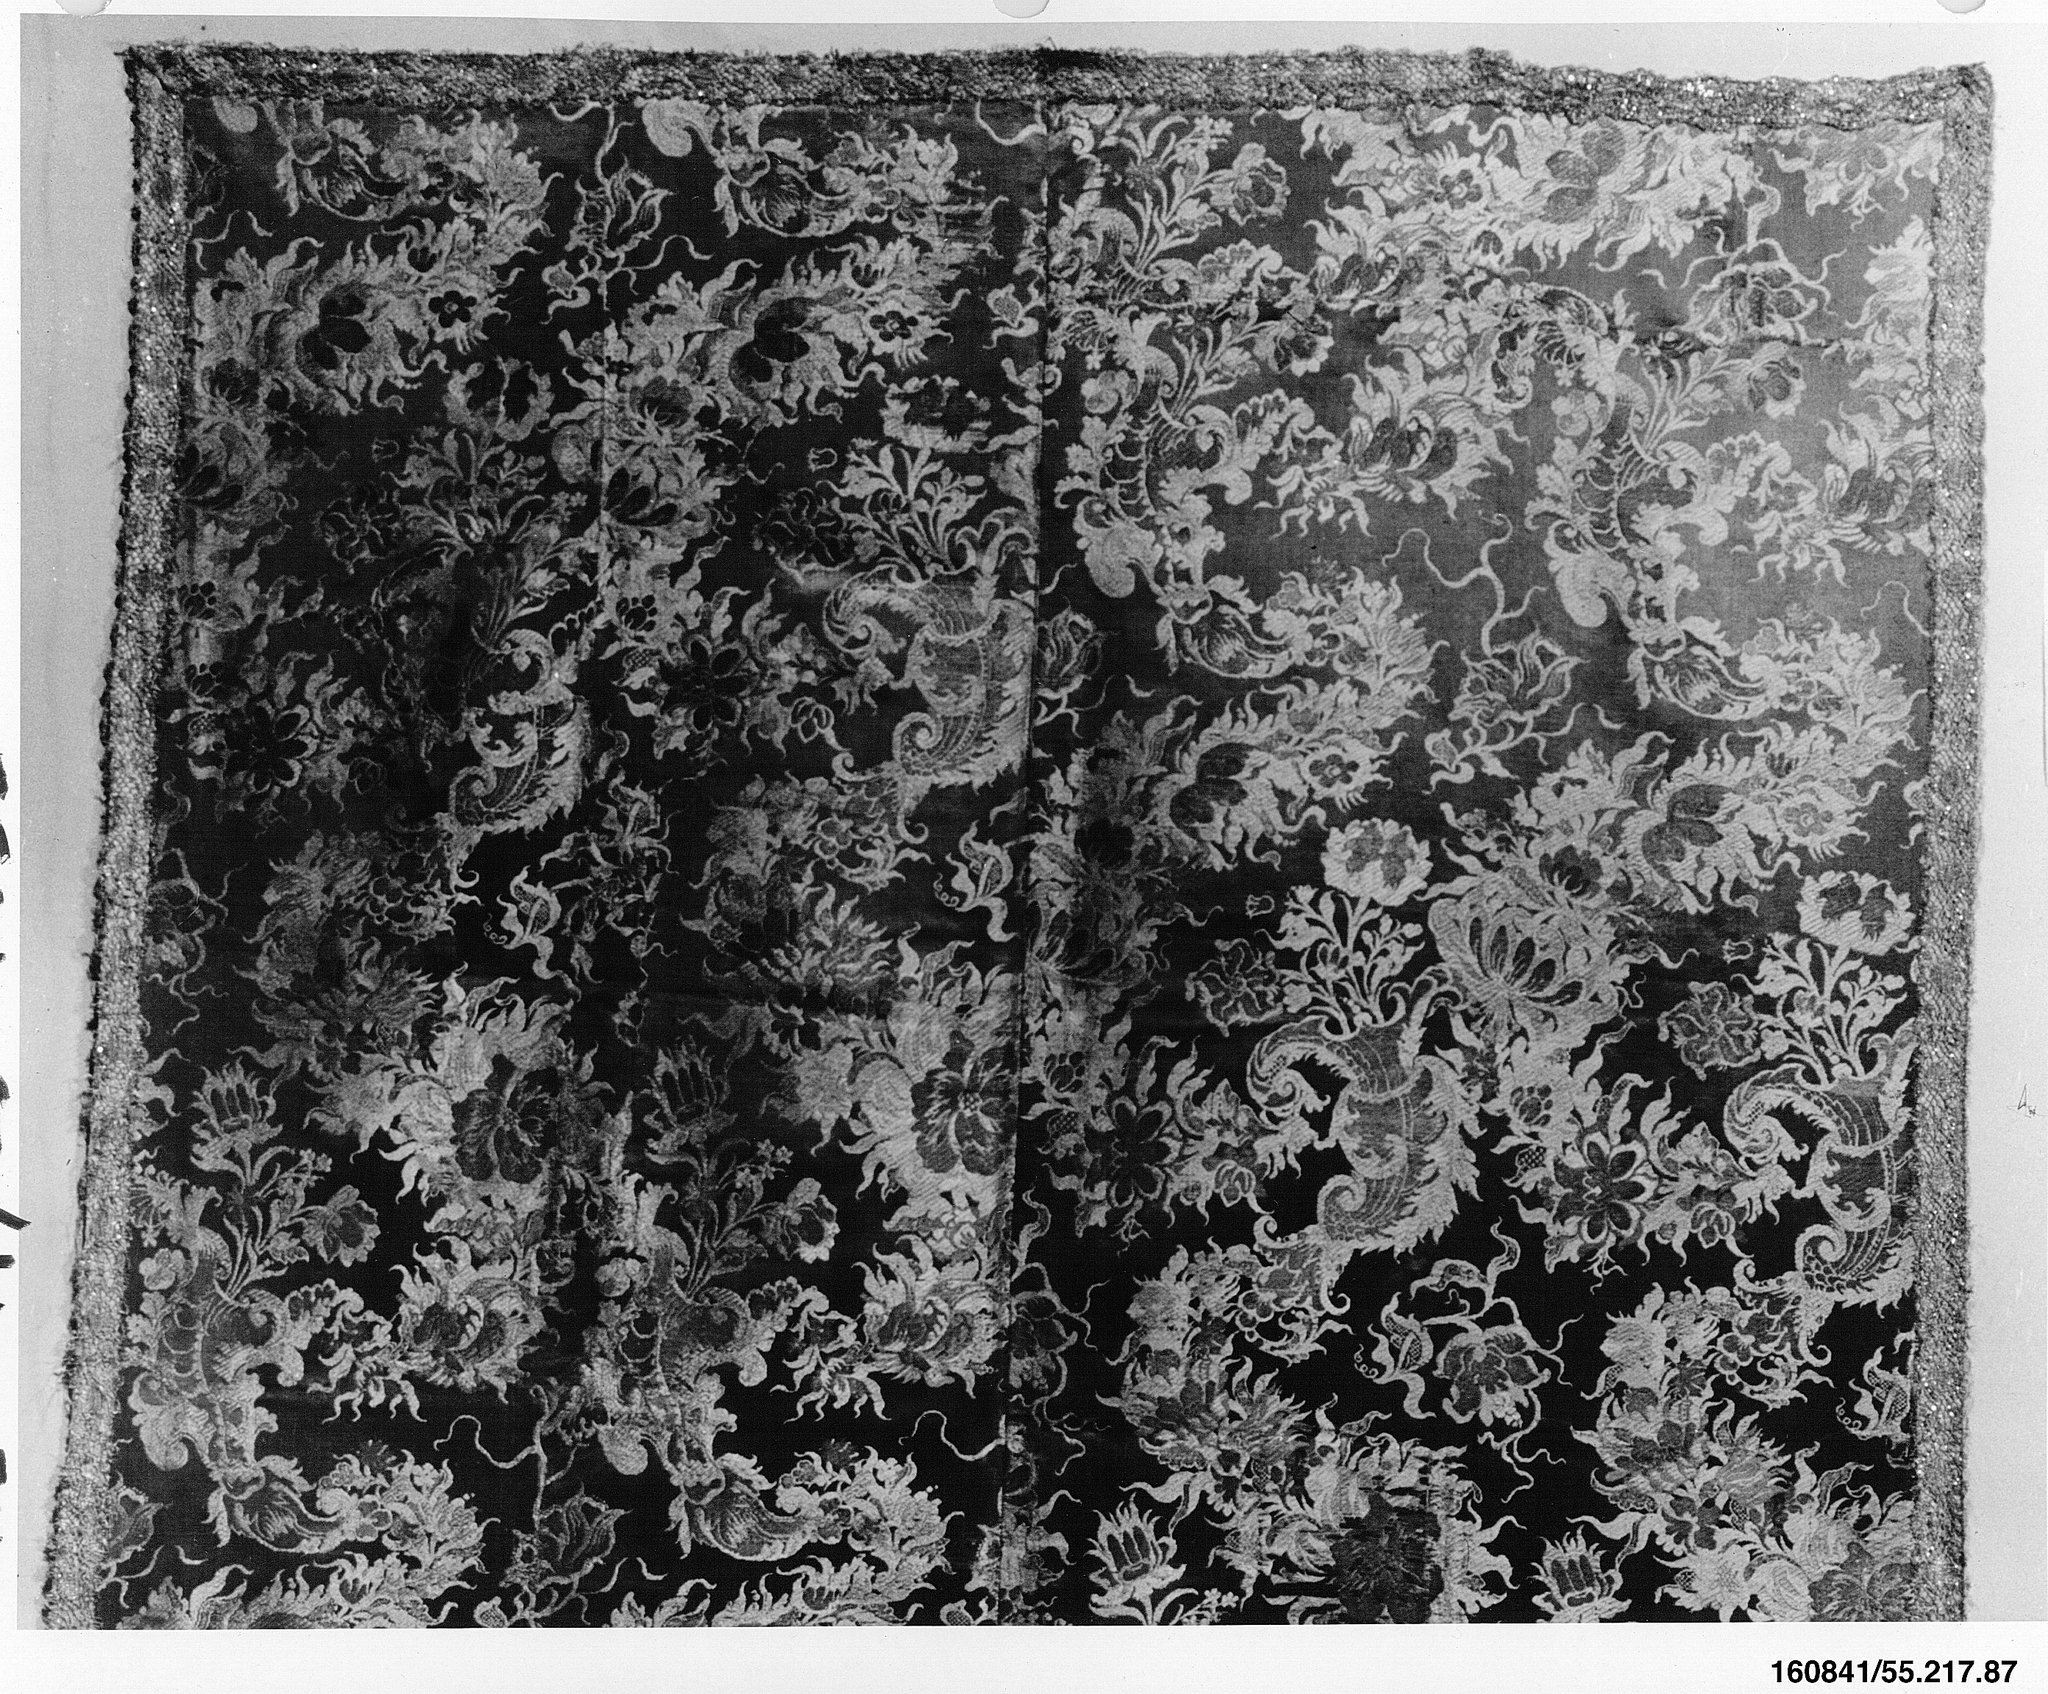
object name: piece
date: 1725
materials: metal thread, silk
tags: flowers